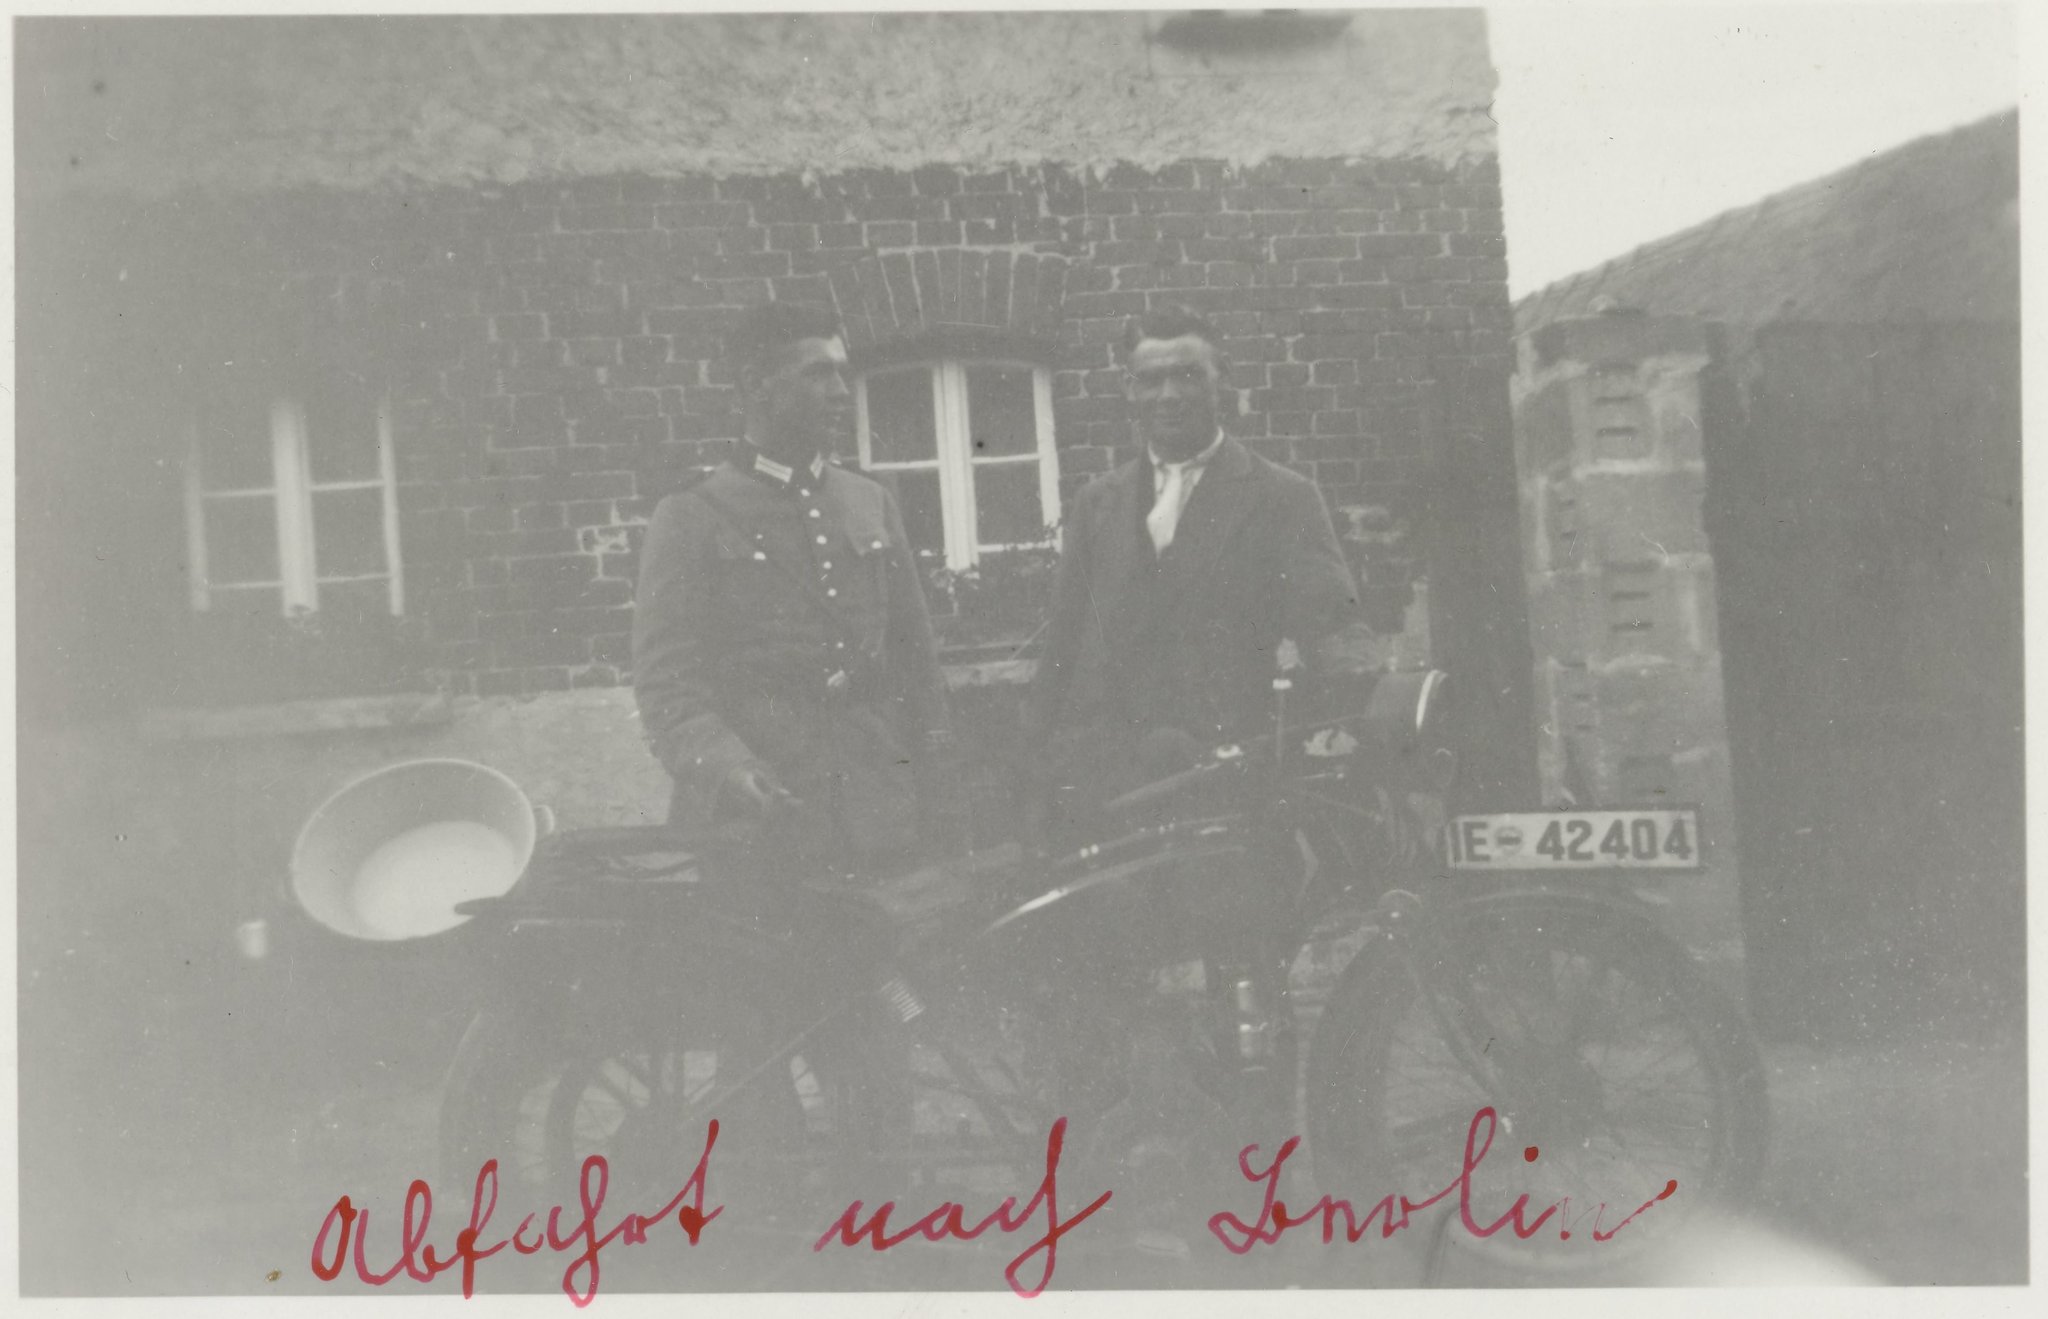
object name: photograph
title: Duitse militair en een man in burger bij een motorfiets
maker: Anonymous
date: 1940-1945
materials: photographic support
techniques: gelatin silver print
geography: germany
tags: germany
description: Een Duitse militair en een man in burger bij een motorfiets met kenteken IE-42404. Met opschrift in rode pen: 'Abfahrt nach ...nolin'. Foto behorend bij album 'Kriegserinnerungen'.